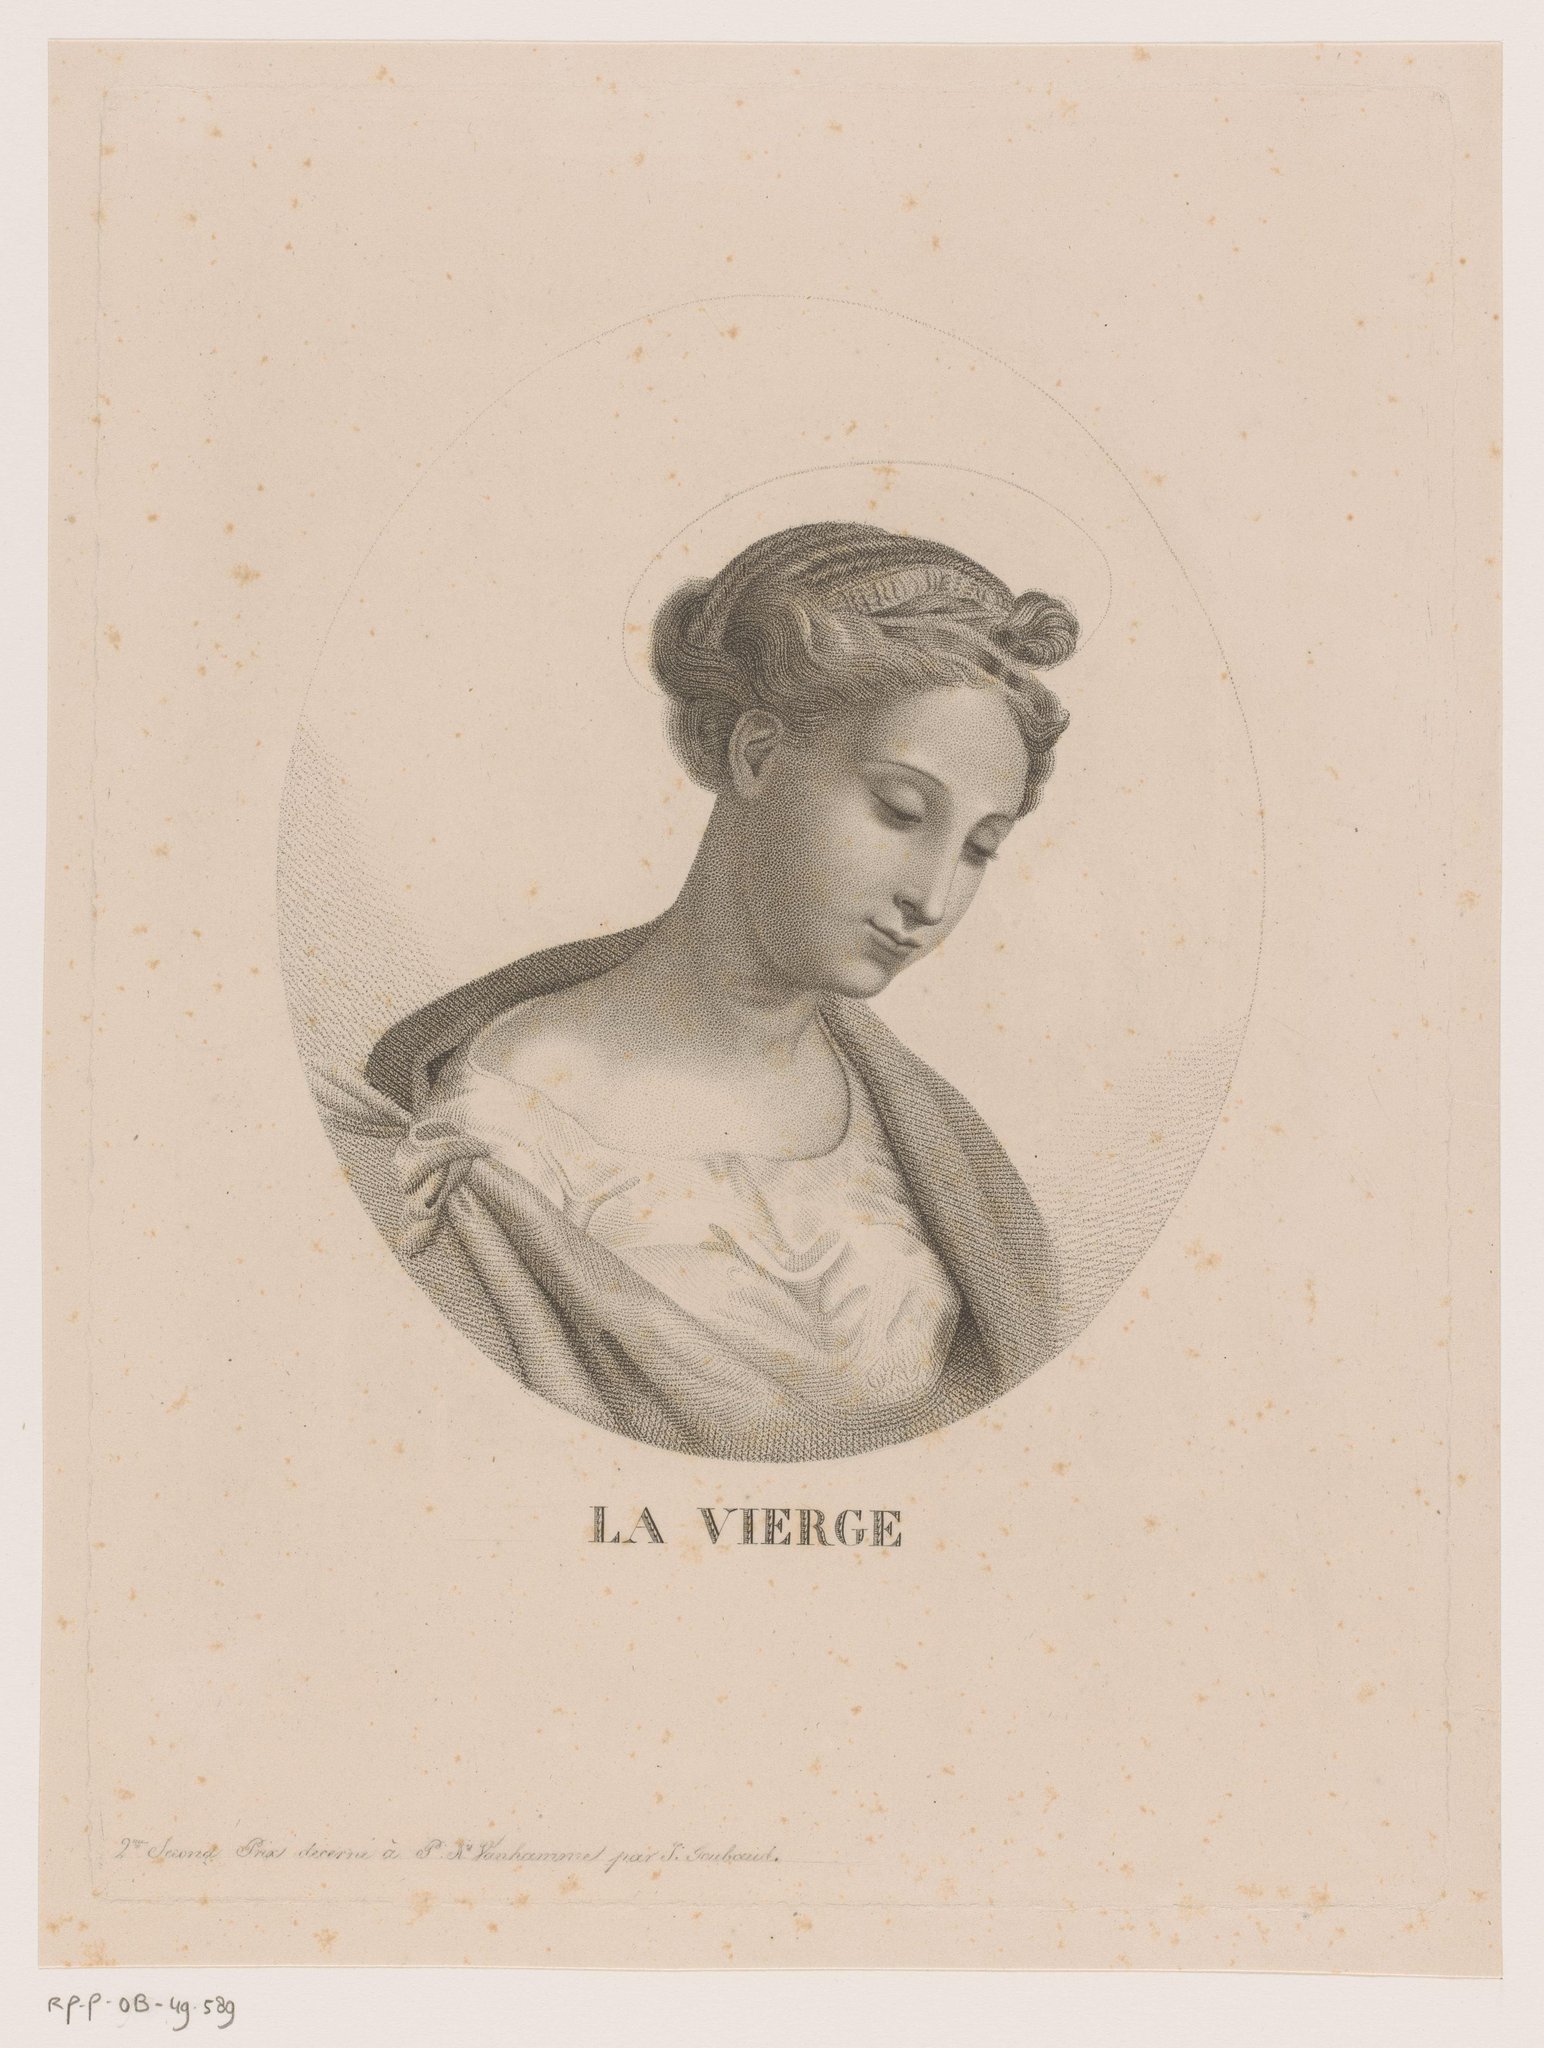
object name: print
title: La Vierge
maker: p.a. vanhamme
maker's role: print maker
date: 1800-1899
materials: paper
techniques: engraving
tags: 'portraits' of mary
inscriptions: collector's mark: Lugt 2228, inscription: ‘2me second prix decerné à P.A. Vanhamme par J. Goubaud’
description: Prent hoort mogelijk bij RP-P-1878-A-834. Het gaat om twee bijna gelijke voorstellingen van Maria met eenzelfde type onderschrift.